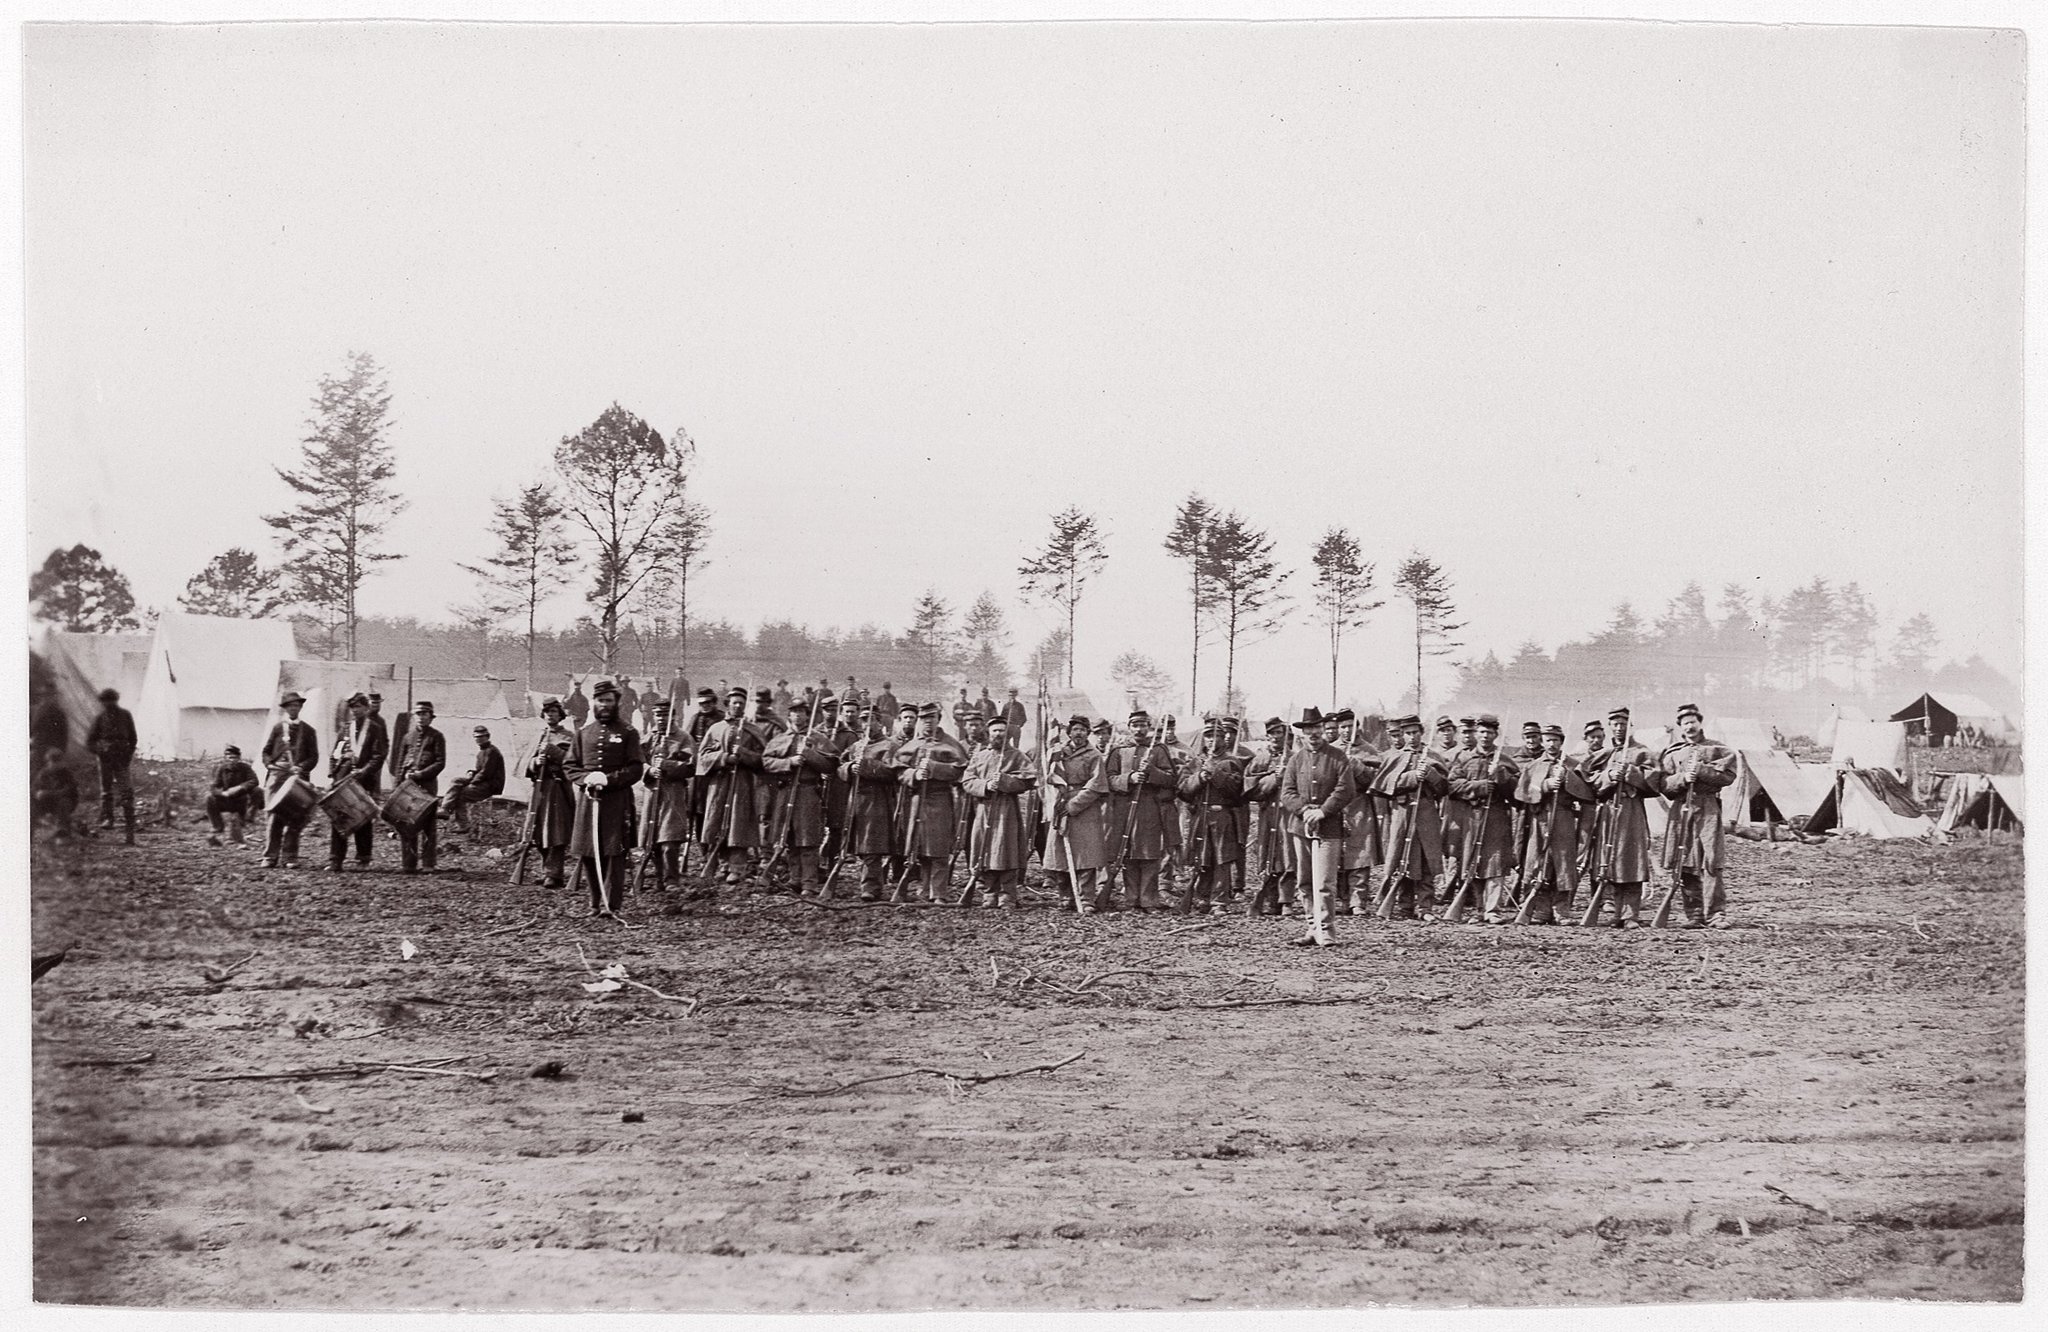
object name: photograph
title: [Regiments - unidentified]. Brady album, p. 156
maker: Anonymous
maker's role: artist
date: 1861-1865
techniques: albumen silver print, glass negative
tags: army,soldiers,american civil war